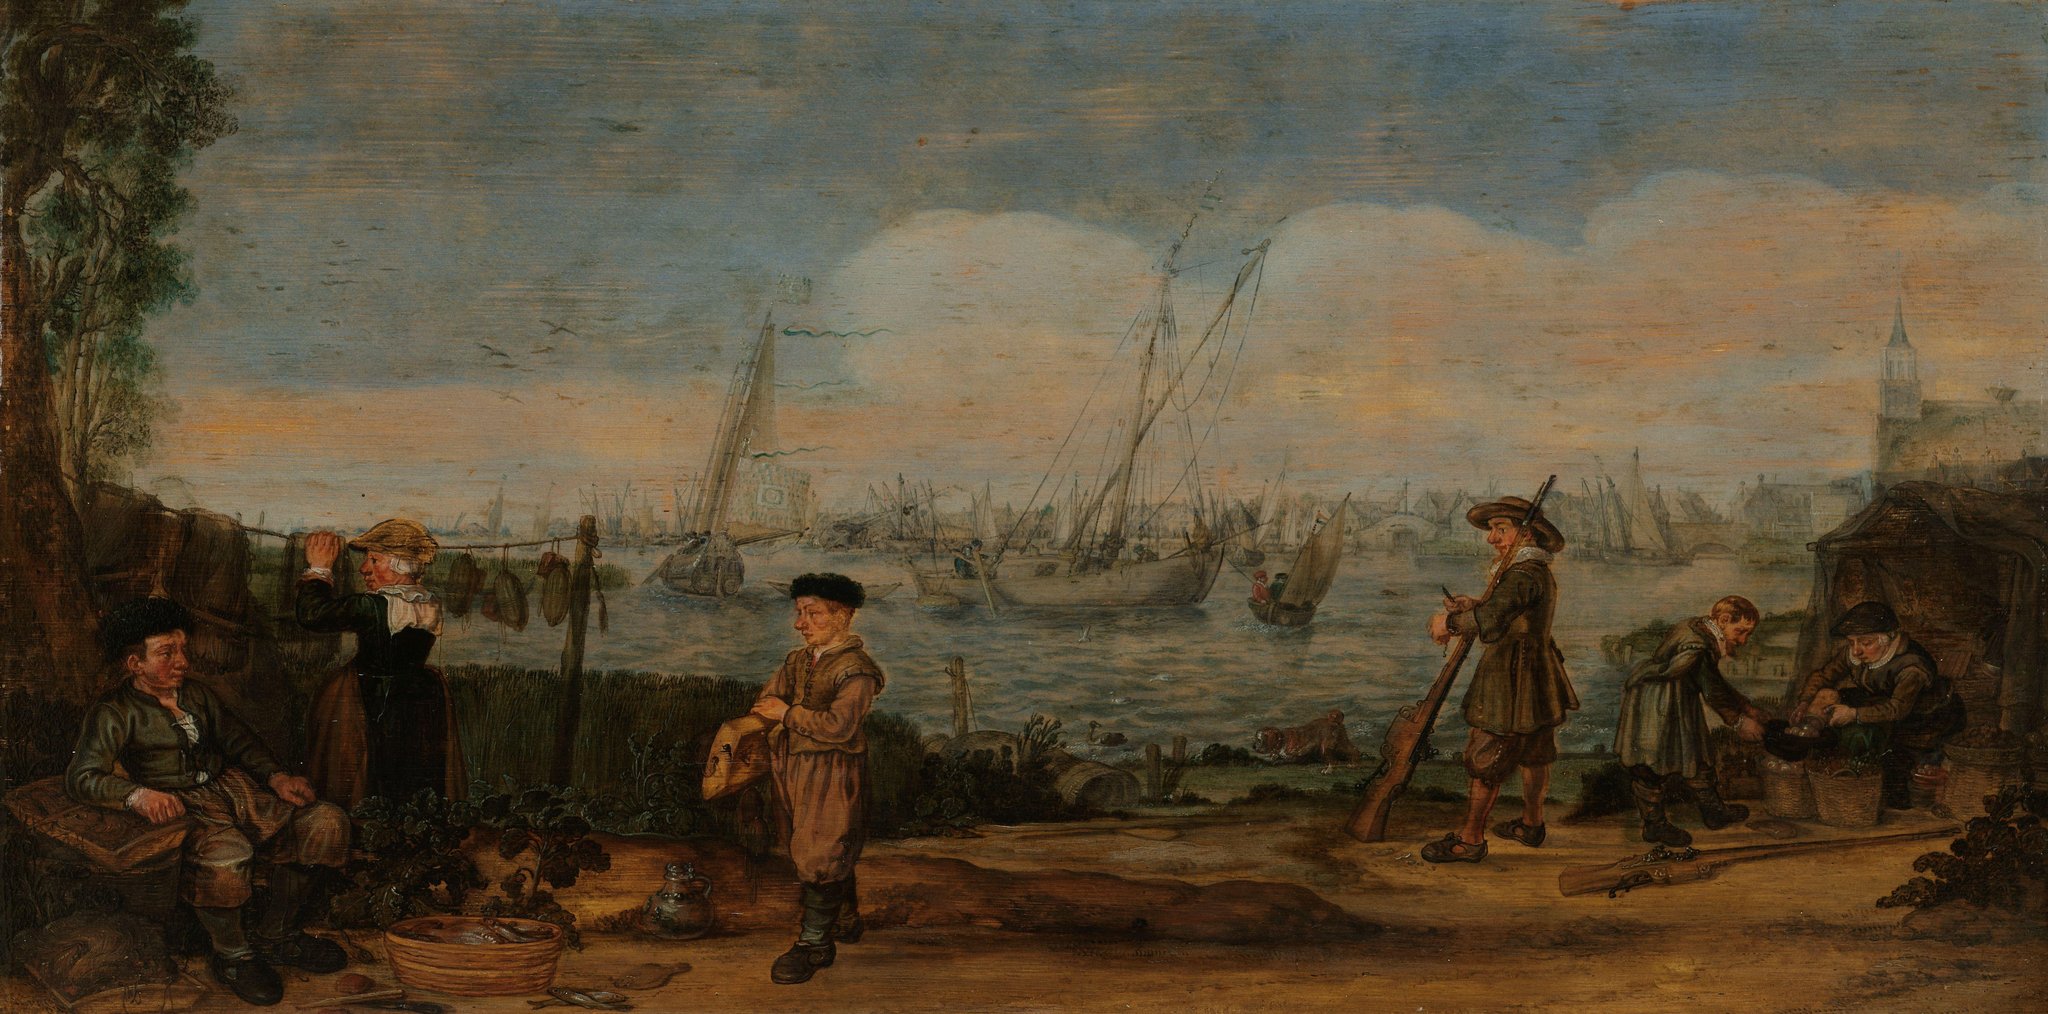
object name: painting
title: Fishermen and Hunters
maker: arent arentsz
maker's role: draughtsman, painter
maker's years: 1585-1631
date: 1625-1630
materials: oil, panel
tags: hunter, coast, sea and coastal fishery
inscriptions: signature, in ligated monogram, at centre on a wooden tray: ‘AA’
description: Kustlandschap met links een groepje vissers met manden met vis en rechts enkele jagers met hun geweren. Op het water zeilen verschillende schepen. Pendant van SK-A-1448.